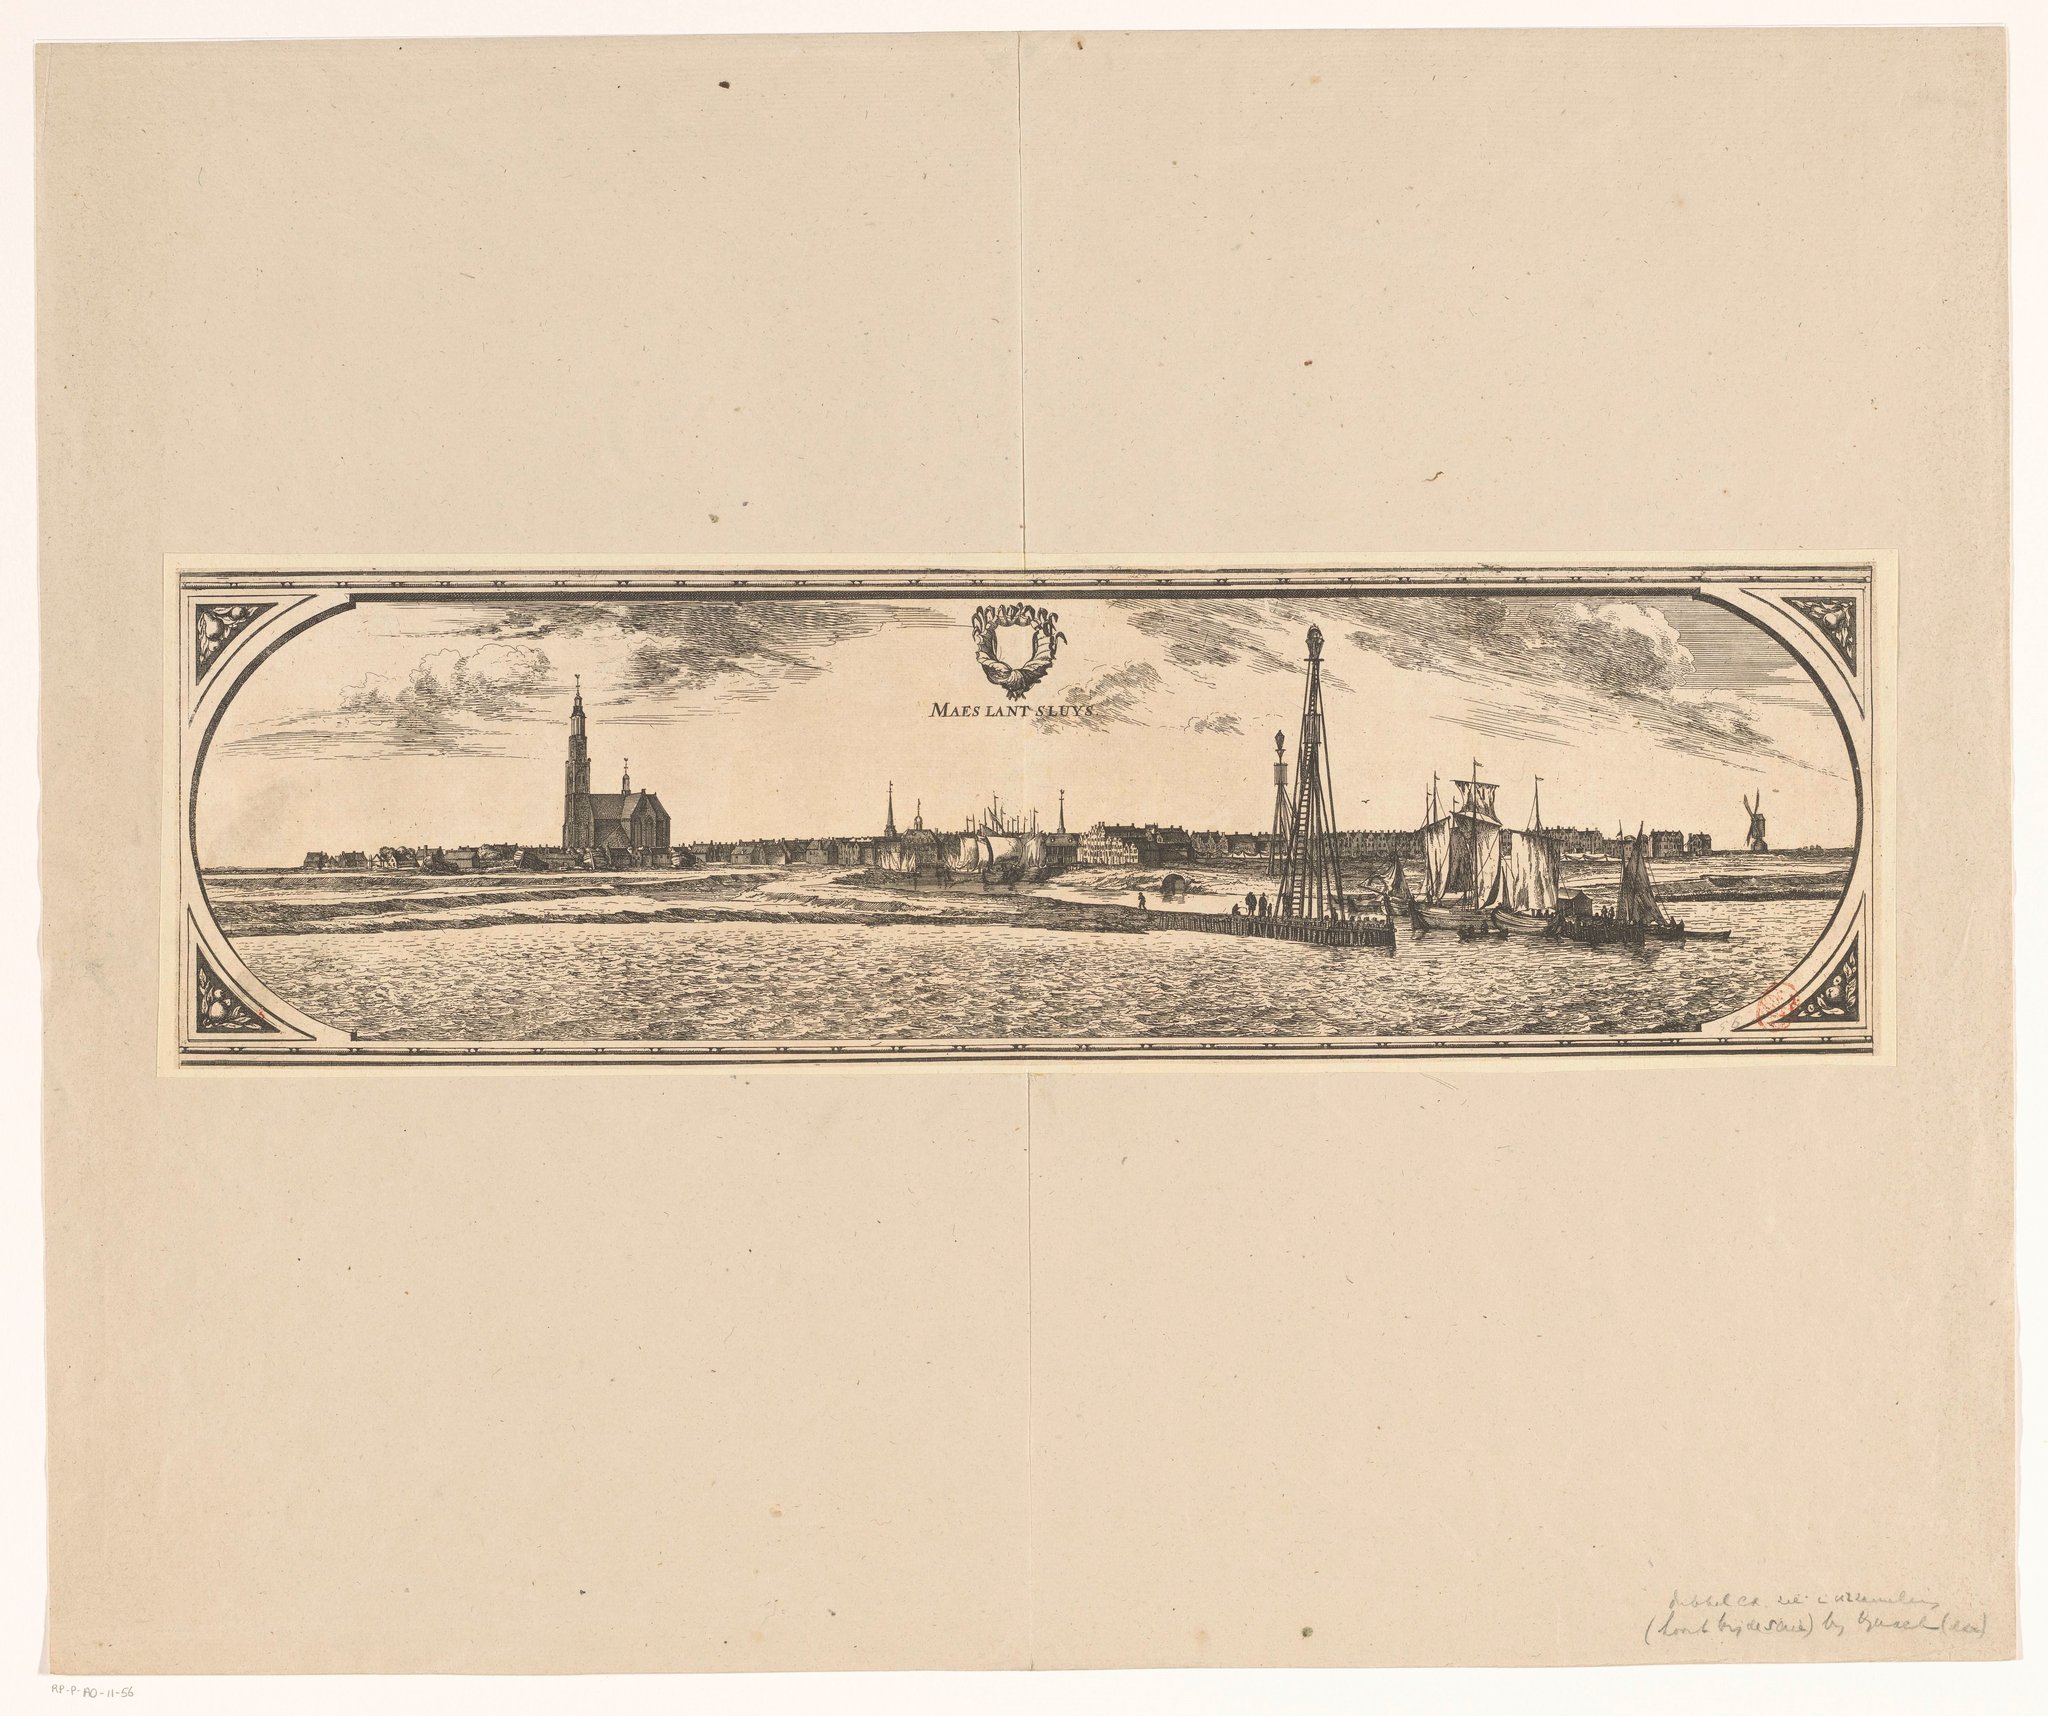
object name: print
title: Gezicht op Maassluis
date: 1666-1698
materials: paper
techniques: engraving, etching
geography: rotterdam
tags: coat of arms (as symbol of the state, etc.) (+ city; municipal), sailing-ship, sailing-boat, church (exterior), windmill, prospect of city, town panorama, silhouette of city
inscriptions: collector's mark: Lugt 195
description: Gezicht op Maassluis gezien vanaf het water. Links de Groote Kerk, ook wel Nieuwe Kerk genoemd. In het water verschillende zeilschepen. Boven in het midden een leeg wapenschild en de titel.